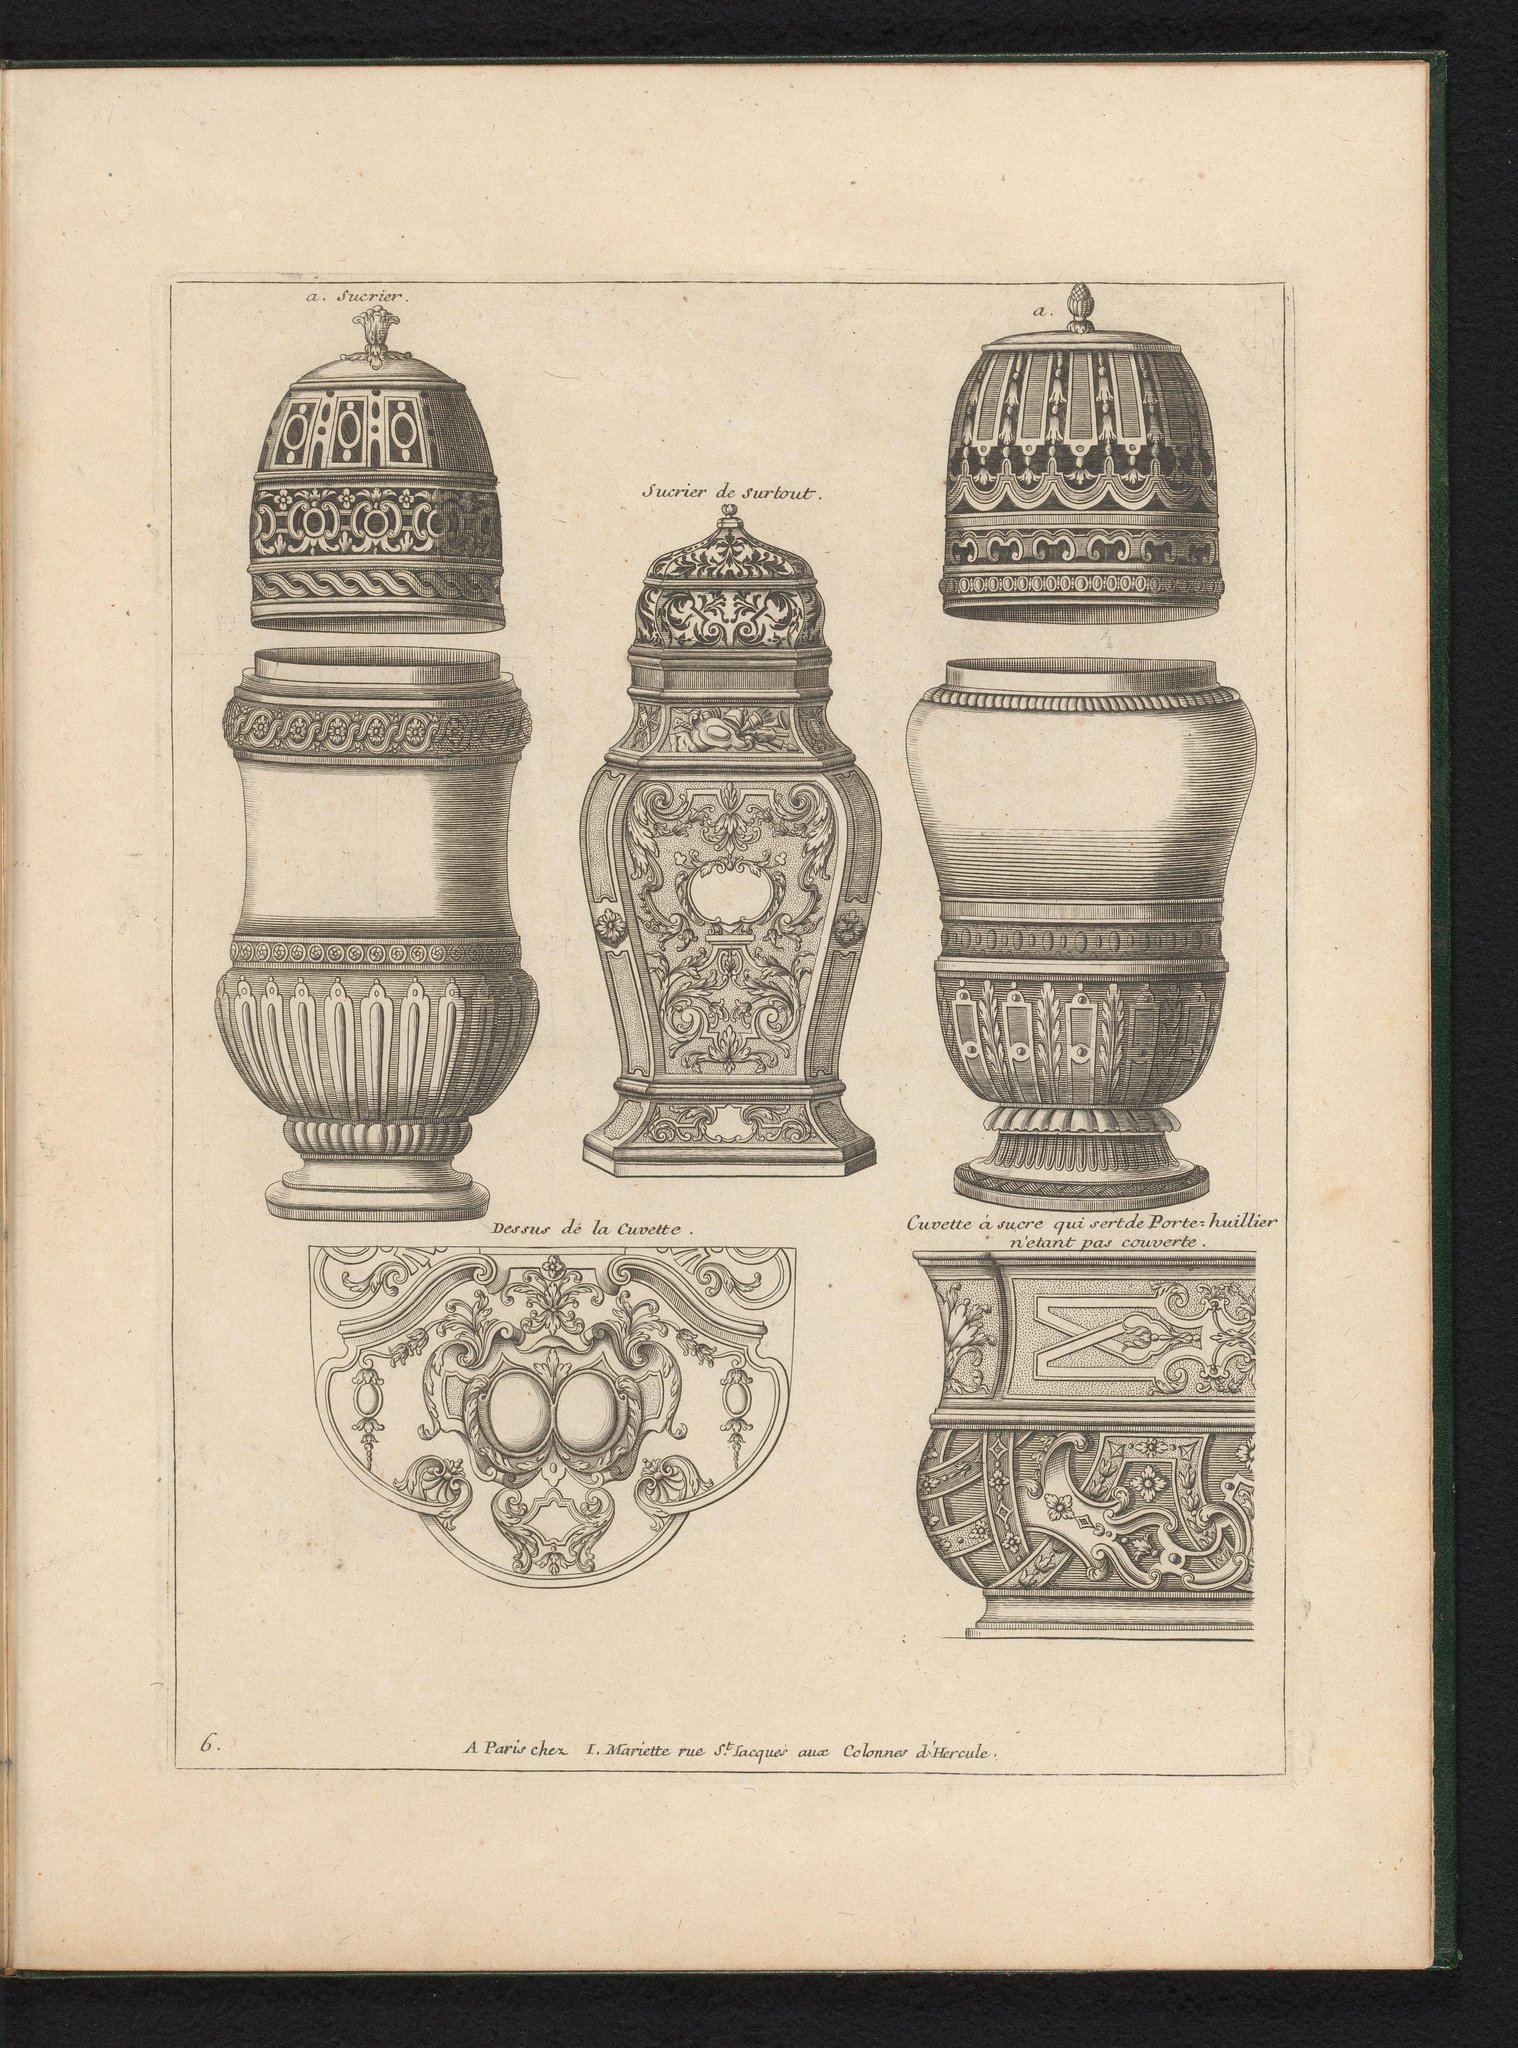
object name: album leaf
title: Ontwerpen voor suikerpotten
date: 1700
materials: paper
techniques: engraving, etching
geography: paris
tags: sugar-basin, jeweller, goldsmith, silversmith, ornamenting, decorating ~ applied arts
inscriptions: collector's mark: Lugt 2228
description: Deze prent maakt deel uit van een album.